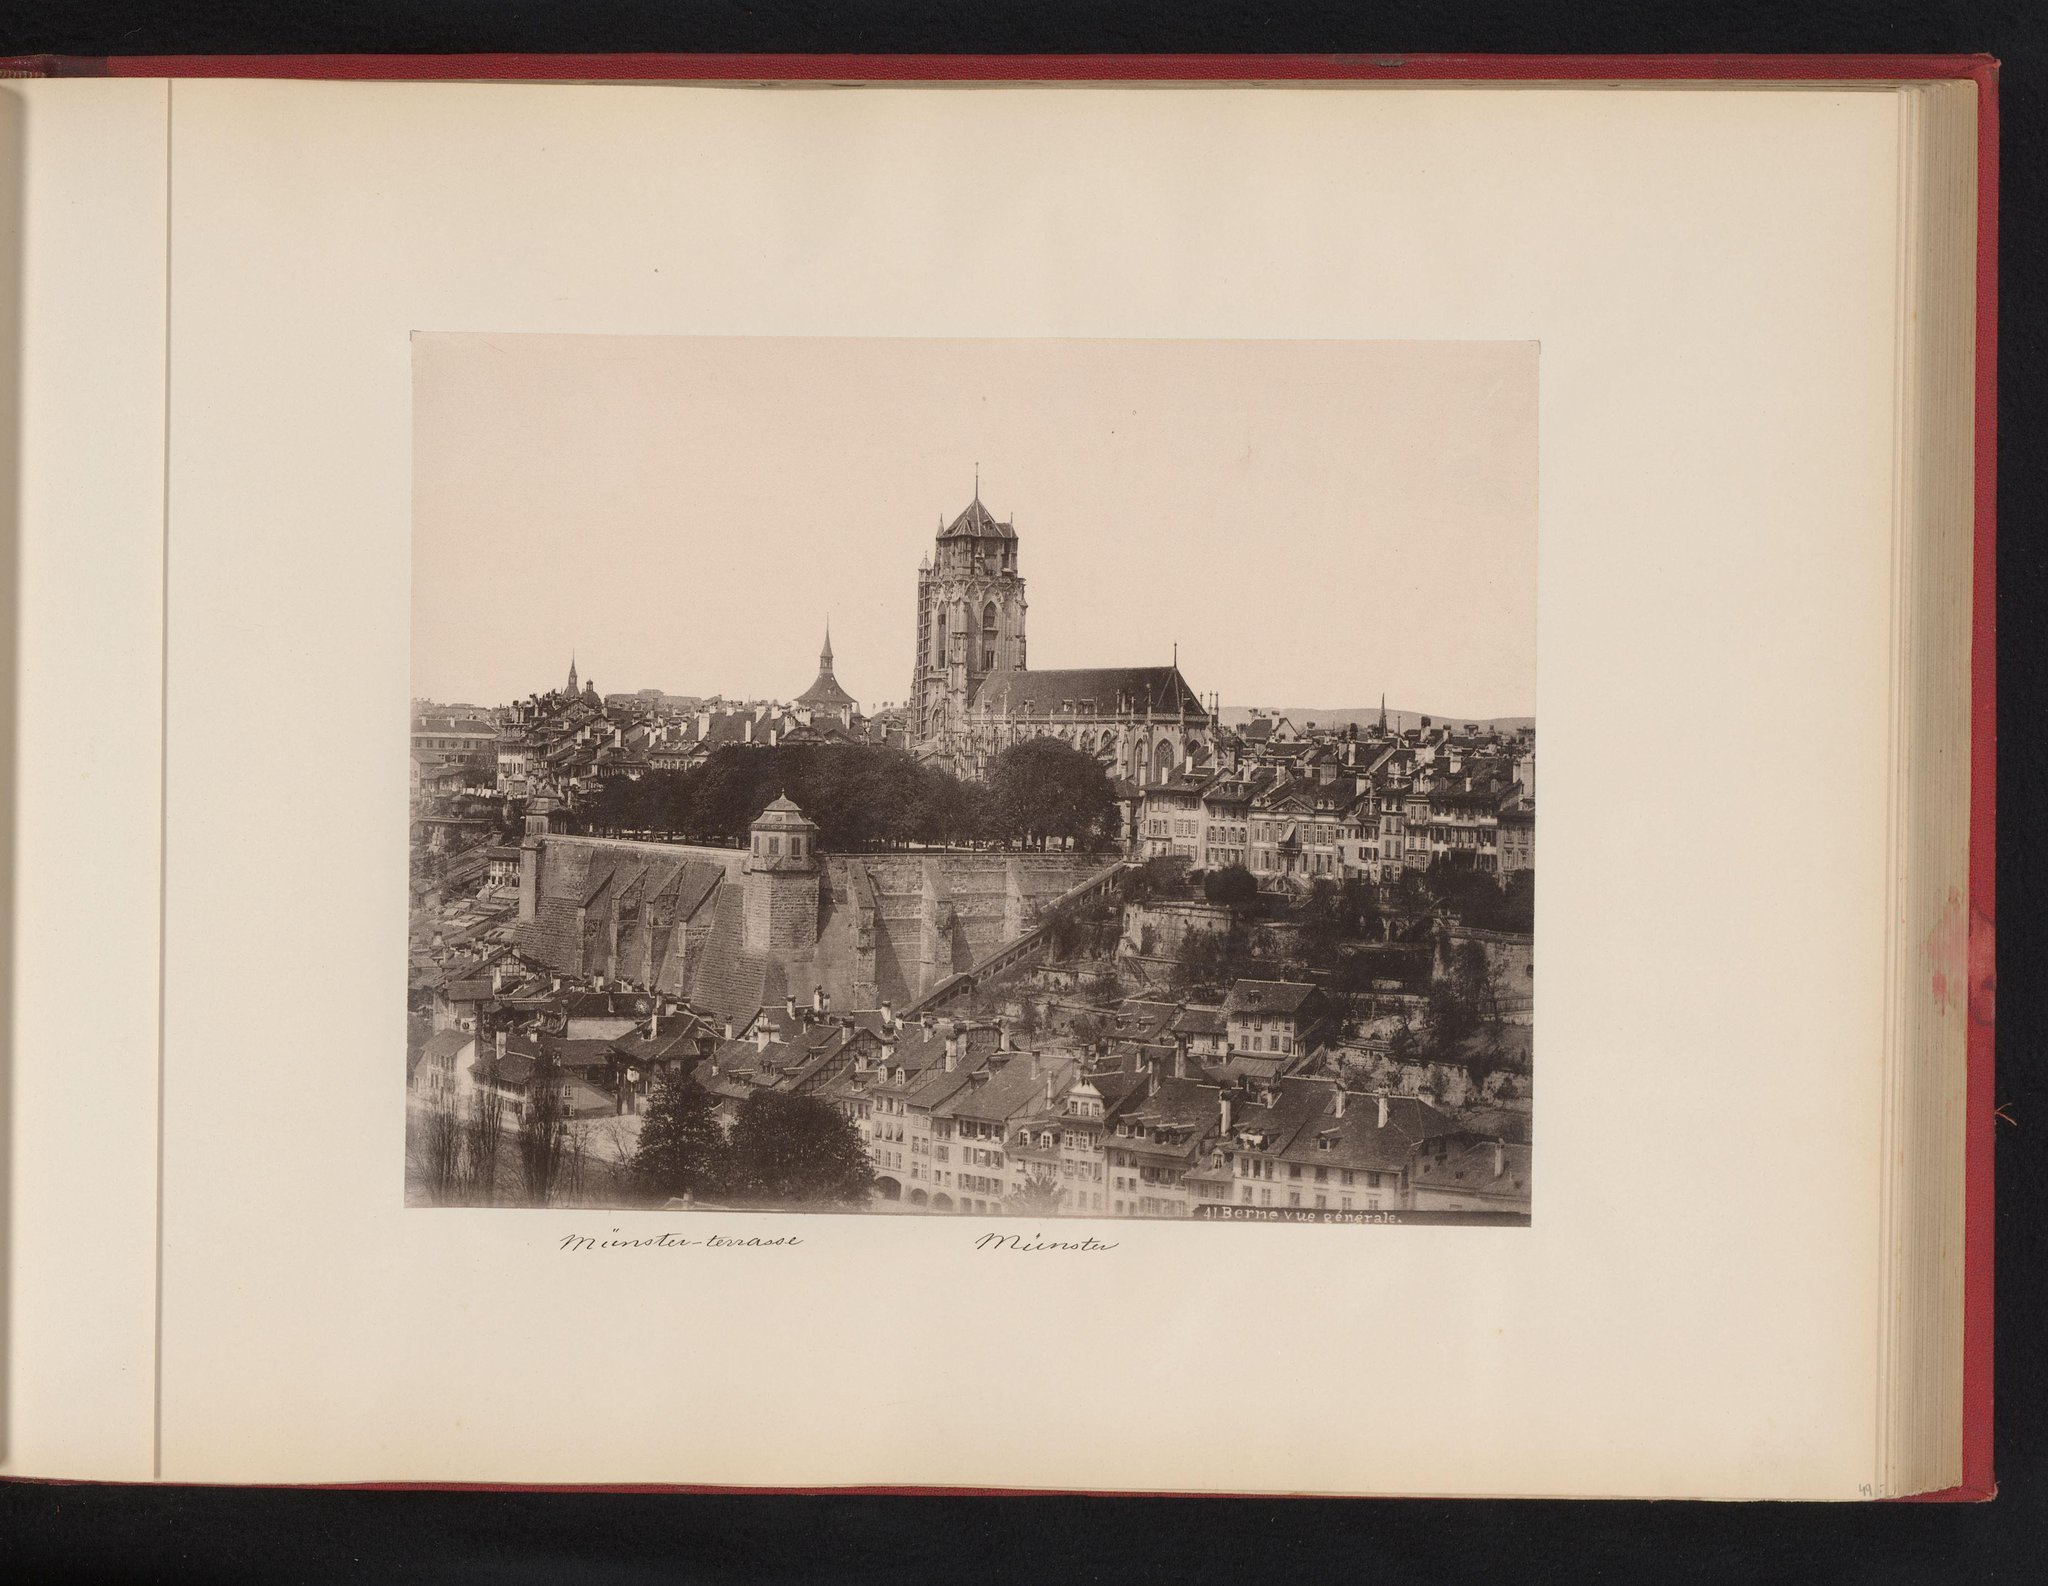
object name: album leaf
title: Stadsgezicht van Bern met de Bern Minster en het Münsterplattform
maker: Anonymous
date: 1880-1893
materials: paper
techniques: photograph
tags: city-view in general; 'veduta', church (exterior)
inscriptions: inscription: ‘41 Berne ue générale.’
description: Deze prent maakt deel uit van een album.